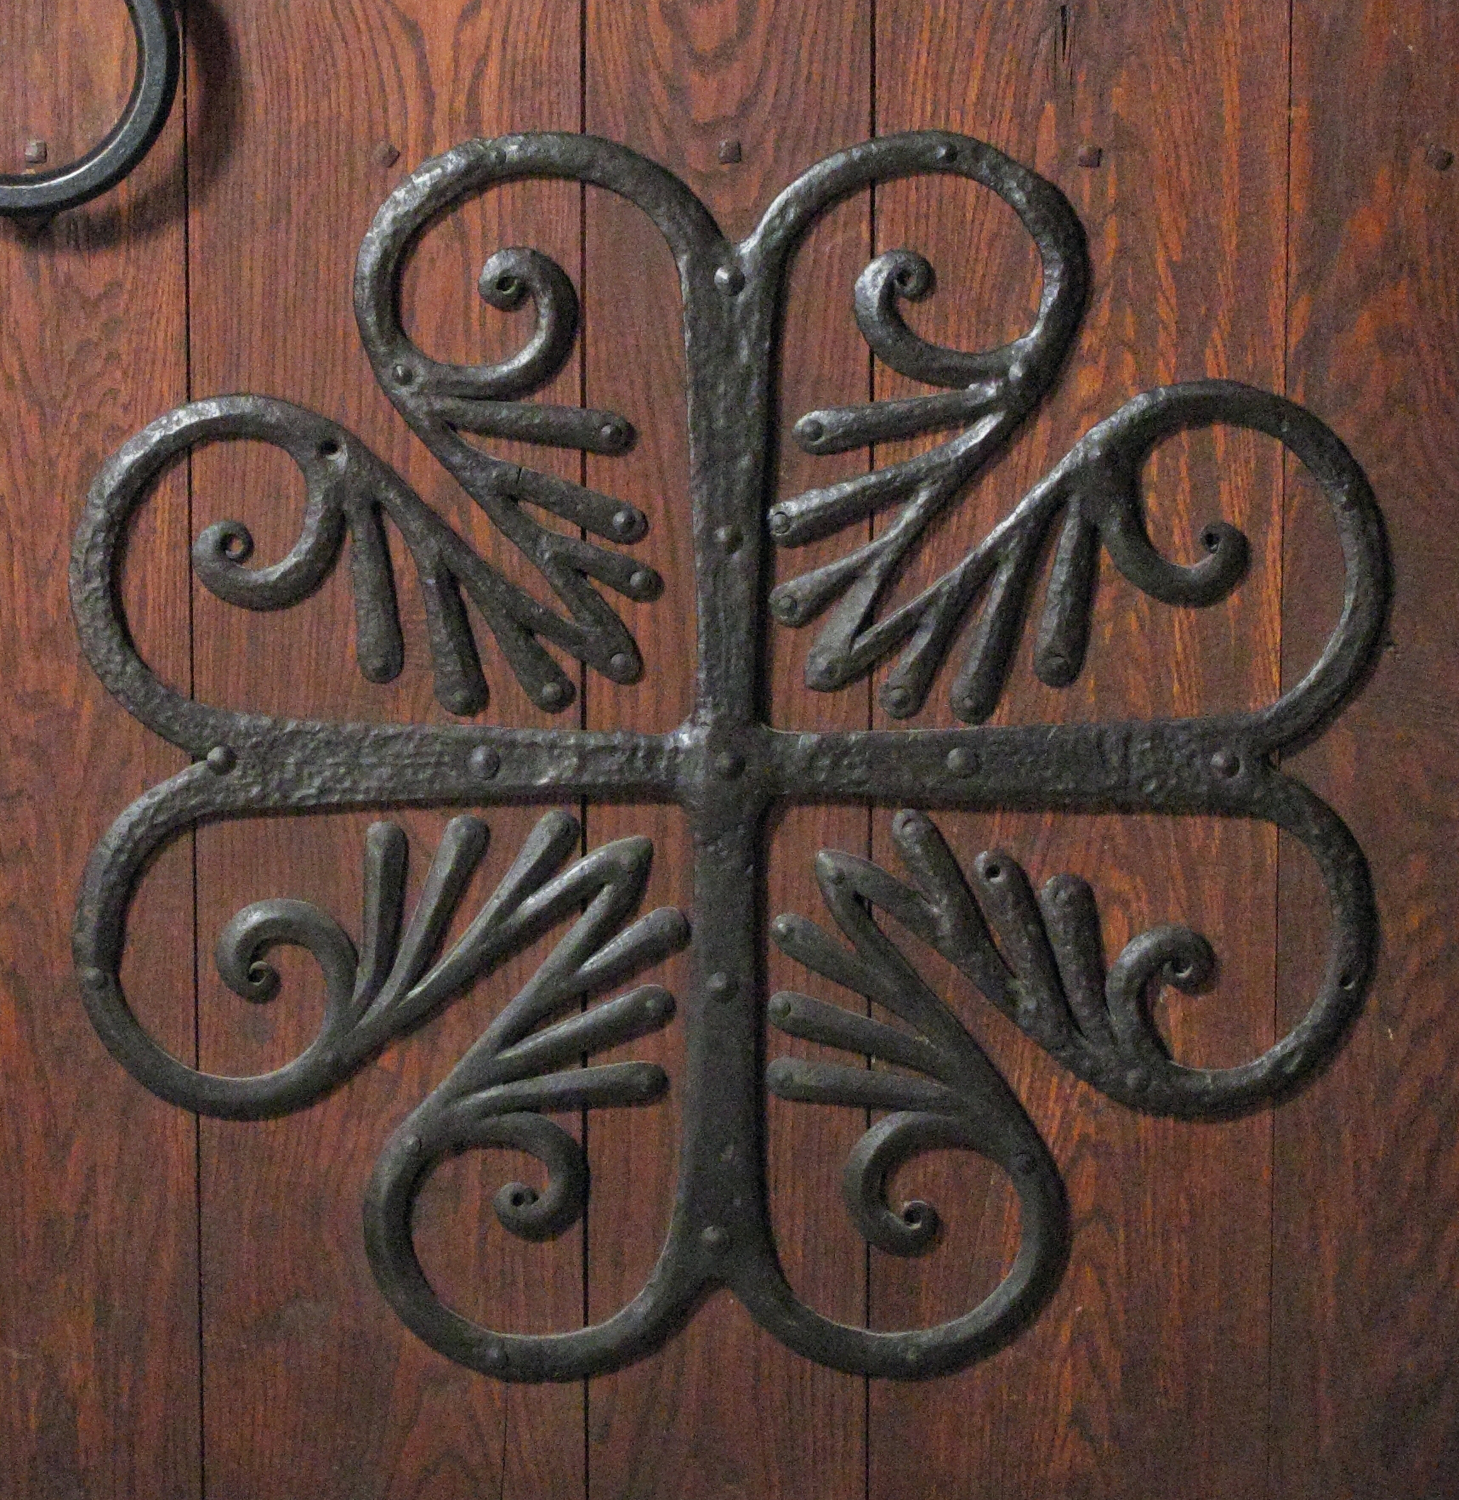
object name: door mount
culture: french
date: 1001-1100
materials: iron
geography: france